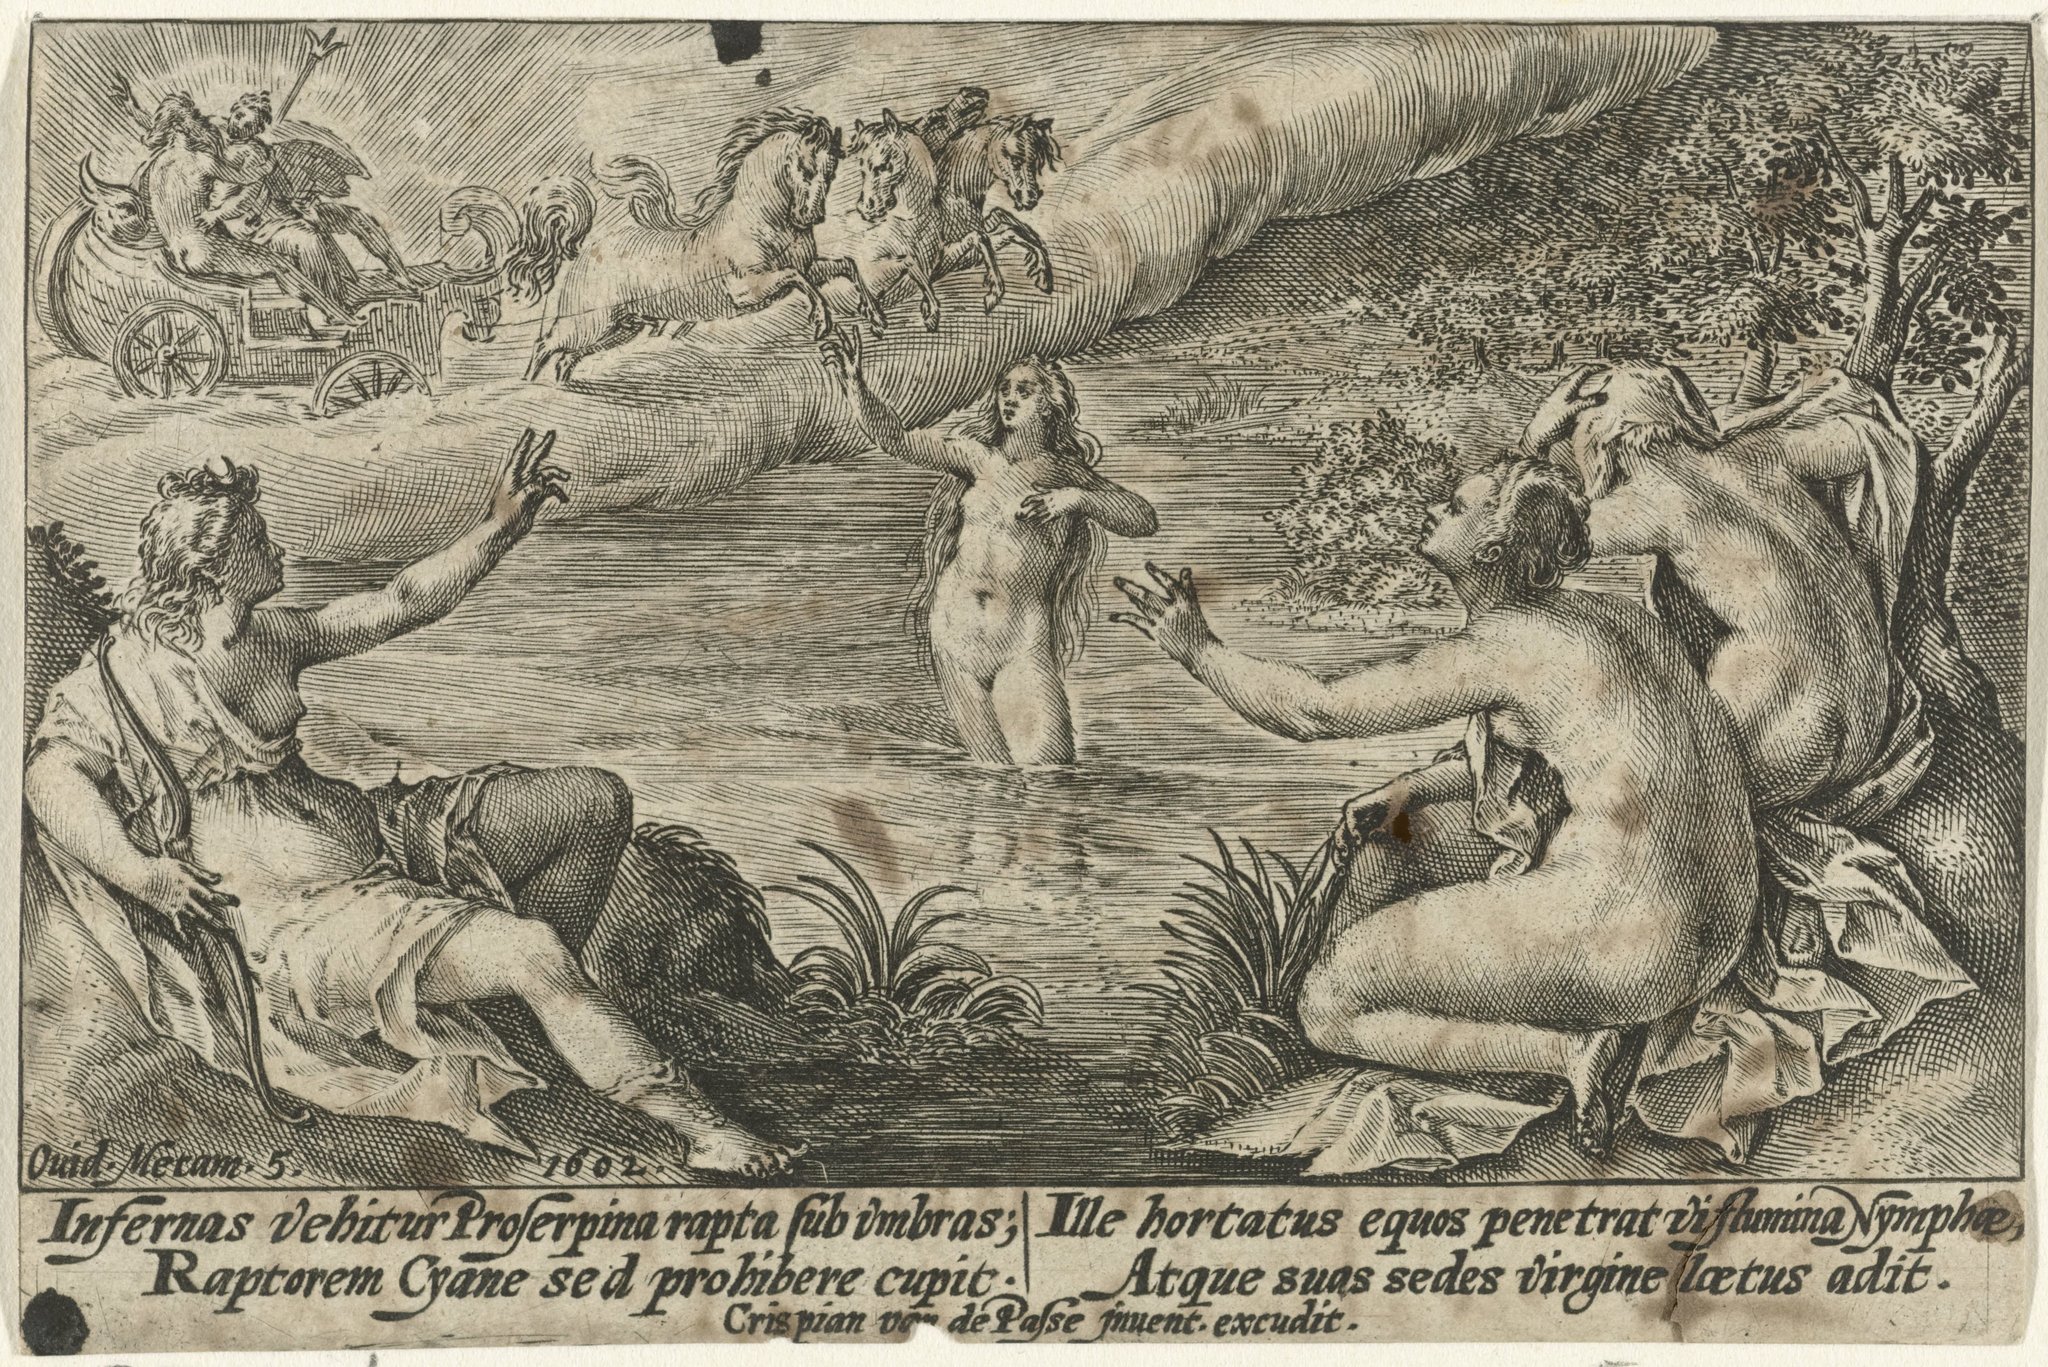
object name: print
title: Metamorfosen van Ovidius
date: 1602-1607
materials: paper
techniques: engraving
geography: cologne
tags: the rape of proserpina (by pluto in his chariot); possibly with diana and minerva trying to rescue her, cyane changed into a fountain: when trying to stop pluto from abducting proserpina, the nymph cyane is changed into a fountain (ovid, metamorphoses v 411)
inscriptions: collector's mark: Lugt 2228, inscription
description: Pluto zit in zijn wagen en ontvoert Proserpina, de dochter van Ceres, naar de onderwereld. Haar vriendinnen en Minerva kijken verschrikt toe vanaf de oever. De nimf Cyane die bedroefd is omdat ze Pluto niet kon tegenhouden huilt en lost op in het water. In de marge een vierregelig onderschrift, in twee kolommen, in het Latijn.